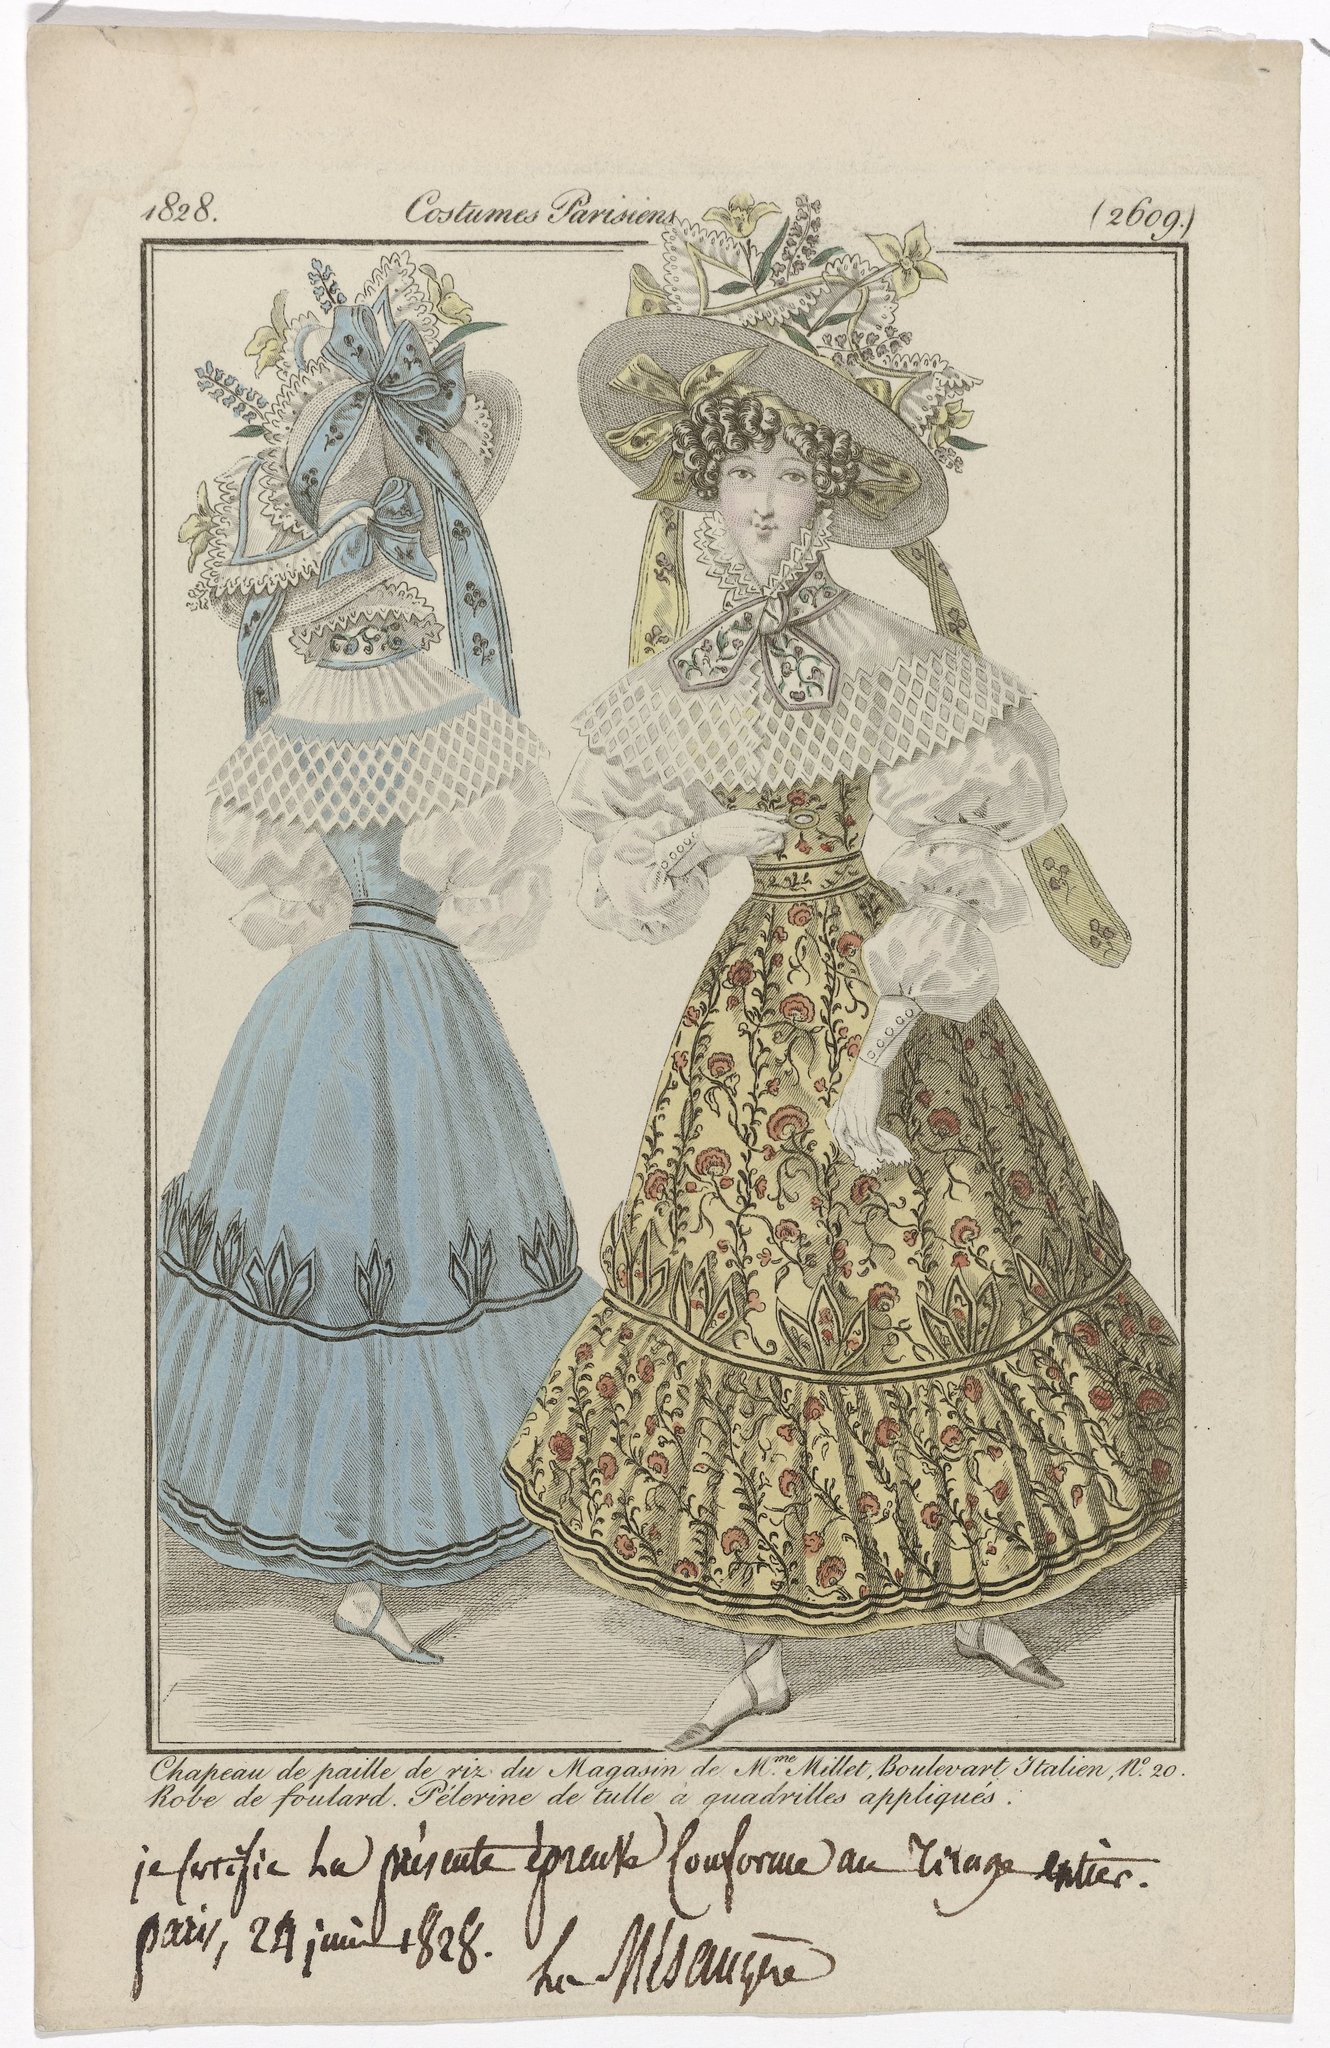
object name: fashion print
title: Journal des Dames et des Modes, Costumes Parisiens, 25 juin 1828, (2609): Chapeau de paille de riz (...)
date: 1828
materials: paper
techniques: engraving, hand coloring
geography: paris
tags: handkerchief (+ women's clothes), clothing for the upper part of the body (pelerine) (+ women's clothes), monocle, single lorgnette - aa - female human figure, fashion plates, head-gear: hat (+ women's clothes), dress, gown (+ women's clothes), neck-gear ~ clothing (+ women's clothes)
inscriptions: caption: ‘je...(onleesbaar)...la..(onleesbaar)...au tirage entier. Paris, 24 juin 1828, La Mésangère’, title: ‘Costumes Parisiens.’, caption: ‘Chapeau de paille de riz du Magasin de Mme Millet, Boulevart Italien, No. 20. Robe de foulard. Pélerine de tulle à quadrilles appliqués.’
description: Hoed van 'paille de riz' uit de winkel van Millet. Japon van foulard. Pelerine van tule met 'quadrilles appliqués'(ruiten). Verdere accessoires: handschoenen, lorgnet, zakdoek, platte schoenen met banden. De prent maakt deel uit van het modetijdschrift Journal des Dames et des Modes, uitgegeven door Pierre de la Mésangère, Parijs, 1797-1839.